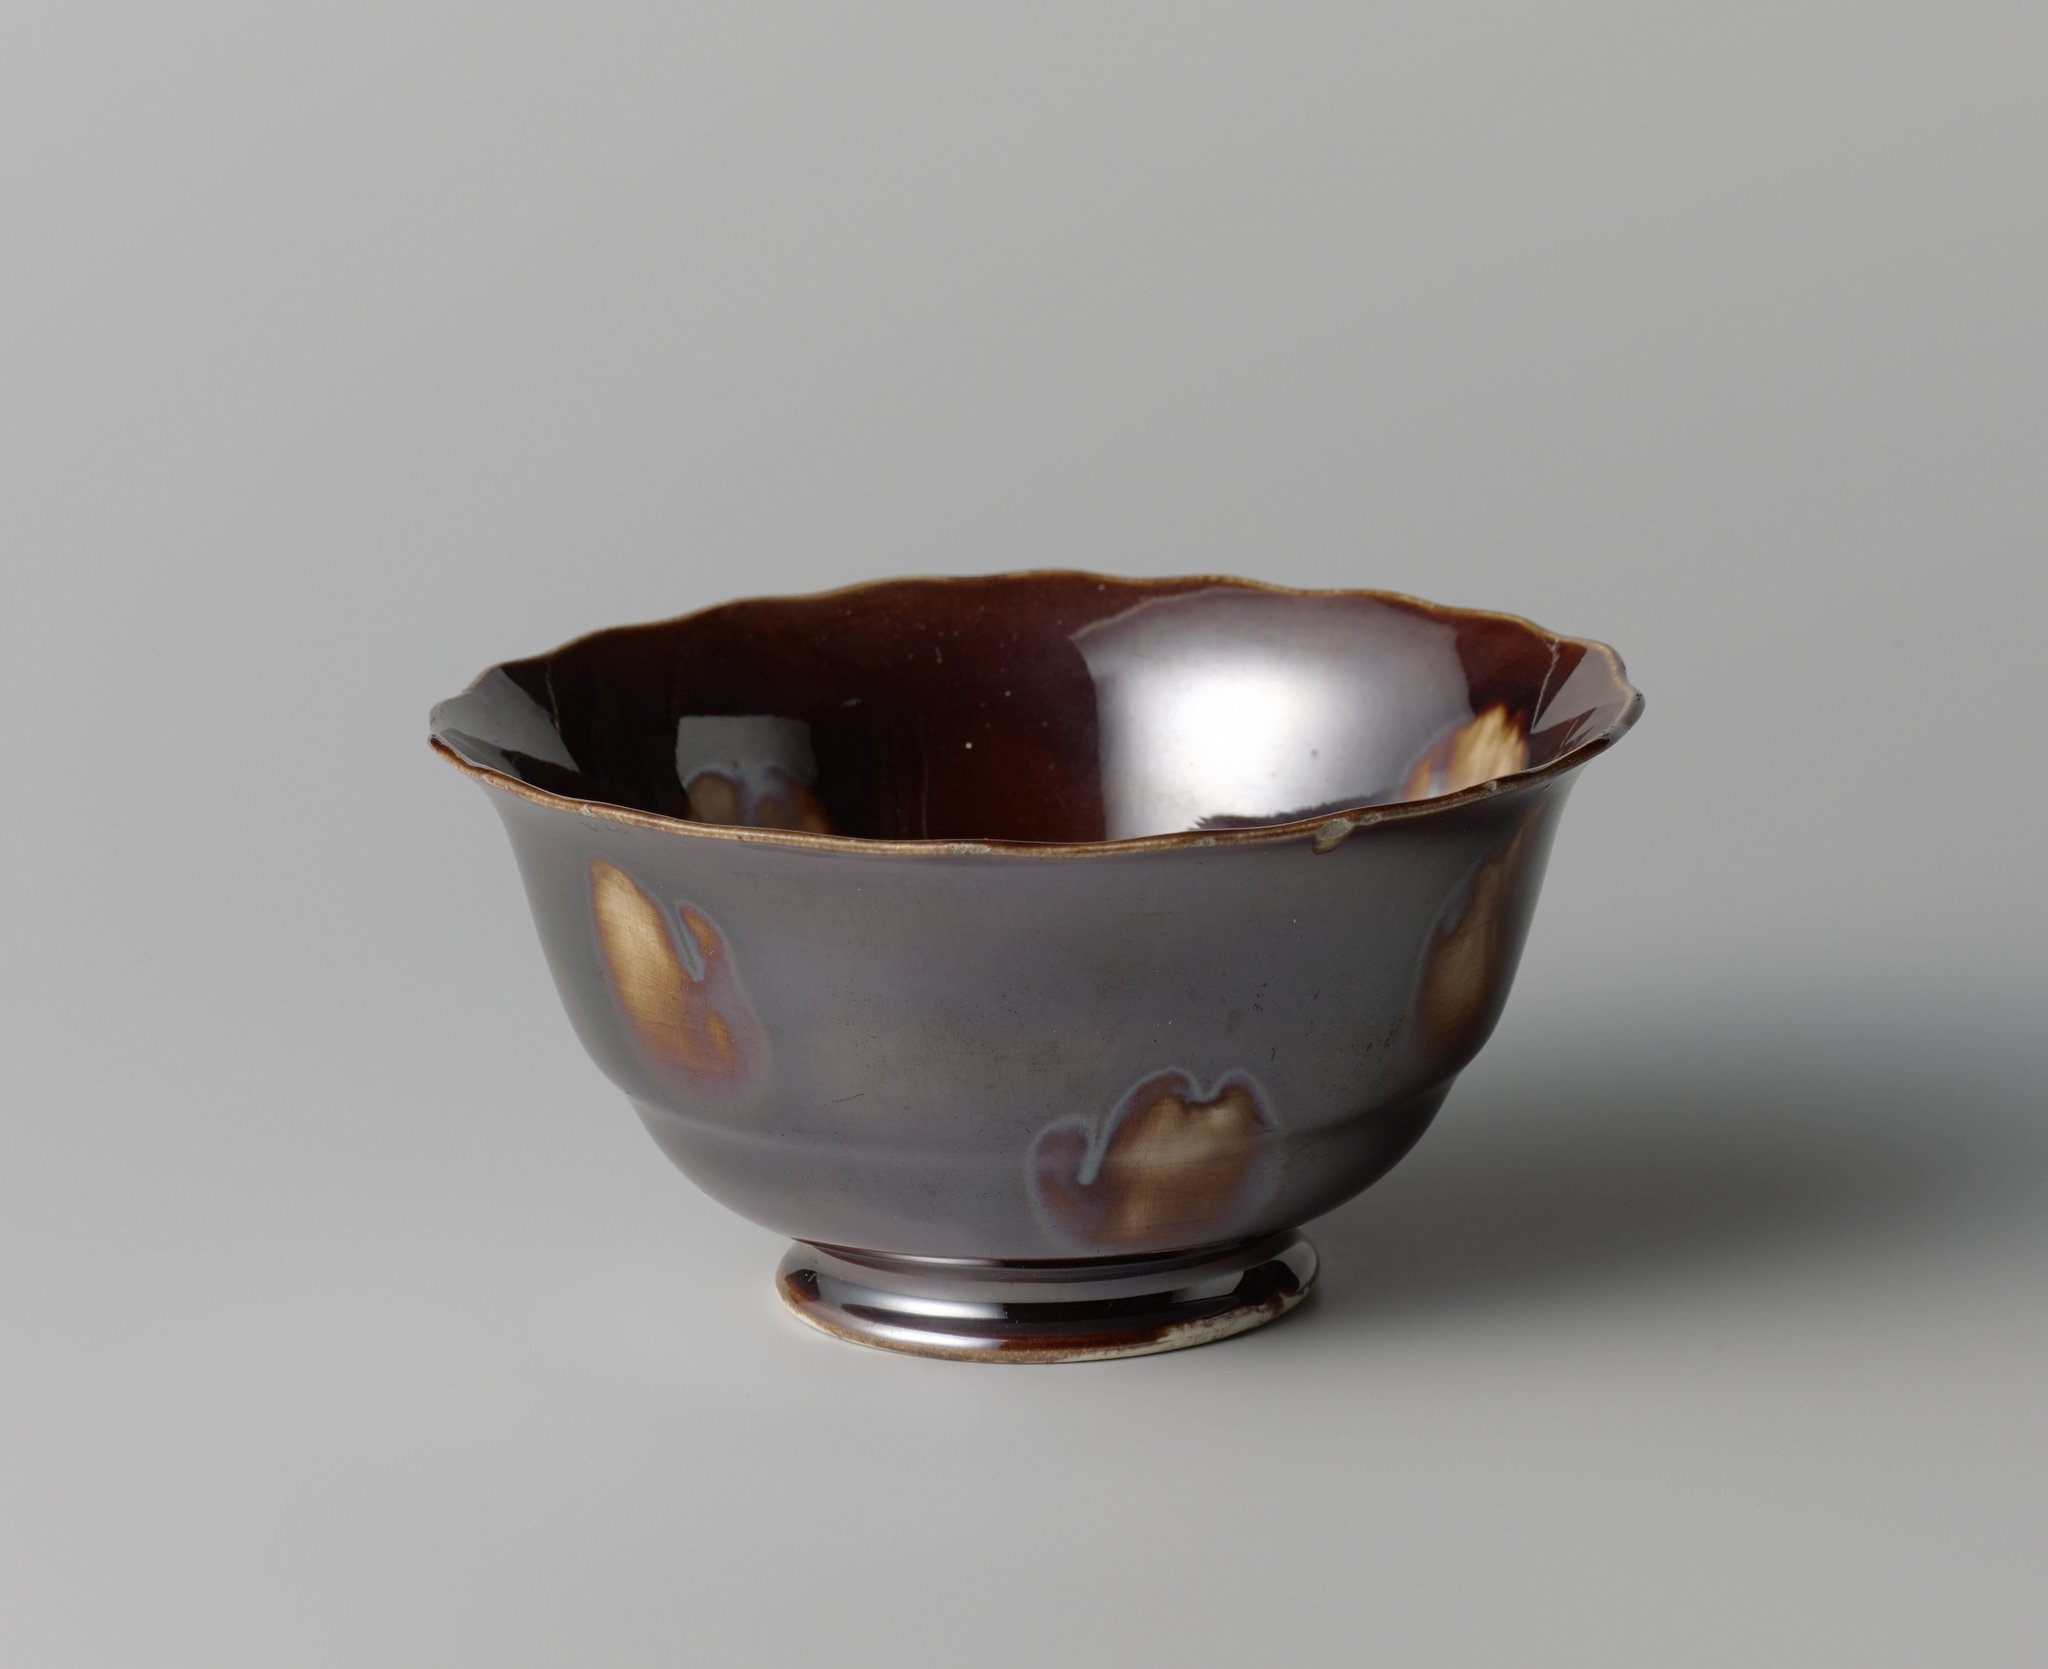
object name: slop bowl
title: Kom, bruin met lichte vlekken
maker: petrus regout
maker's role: plateelbakker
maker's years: 1801-1879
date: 1801-1879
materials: earthenware, glaze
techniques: vitrification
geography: maastricht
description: Kom van aardewerk met bruine lusterglazuur. Op de buik lichte vlekken.